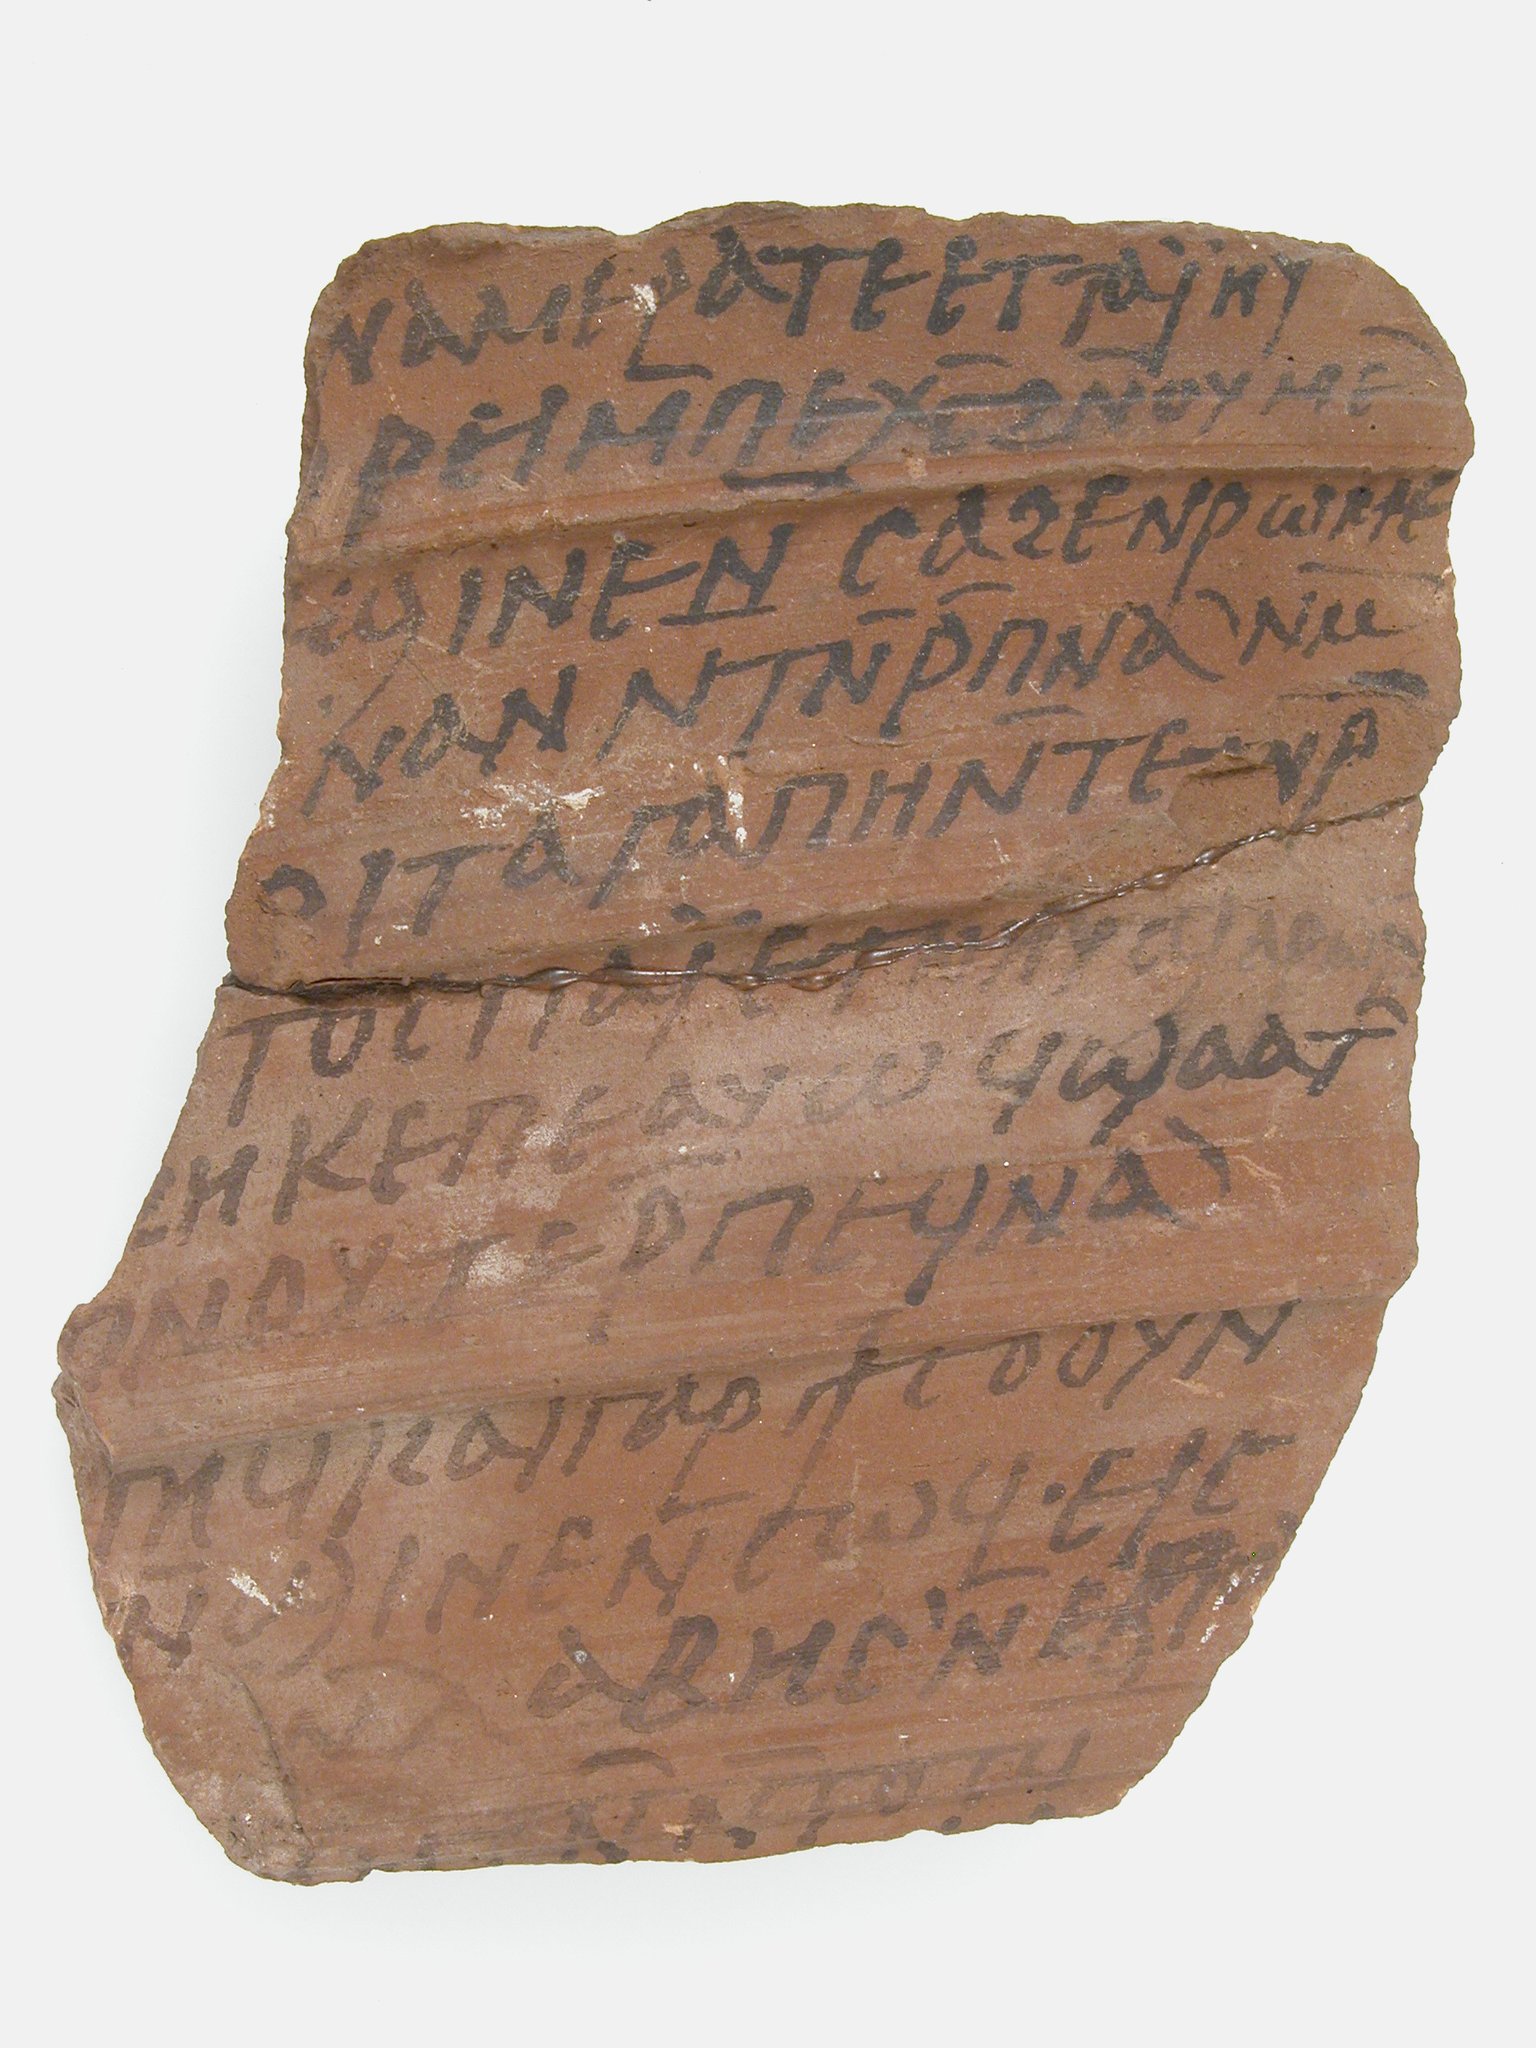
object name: ostrakon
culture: coptic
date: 601-700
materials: ink, pottery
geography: egypt